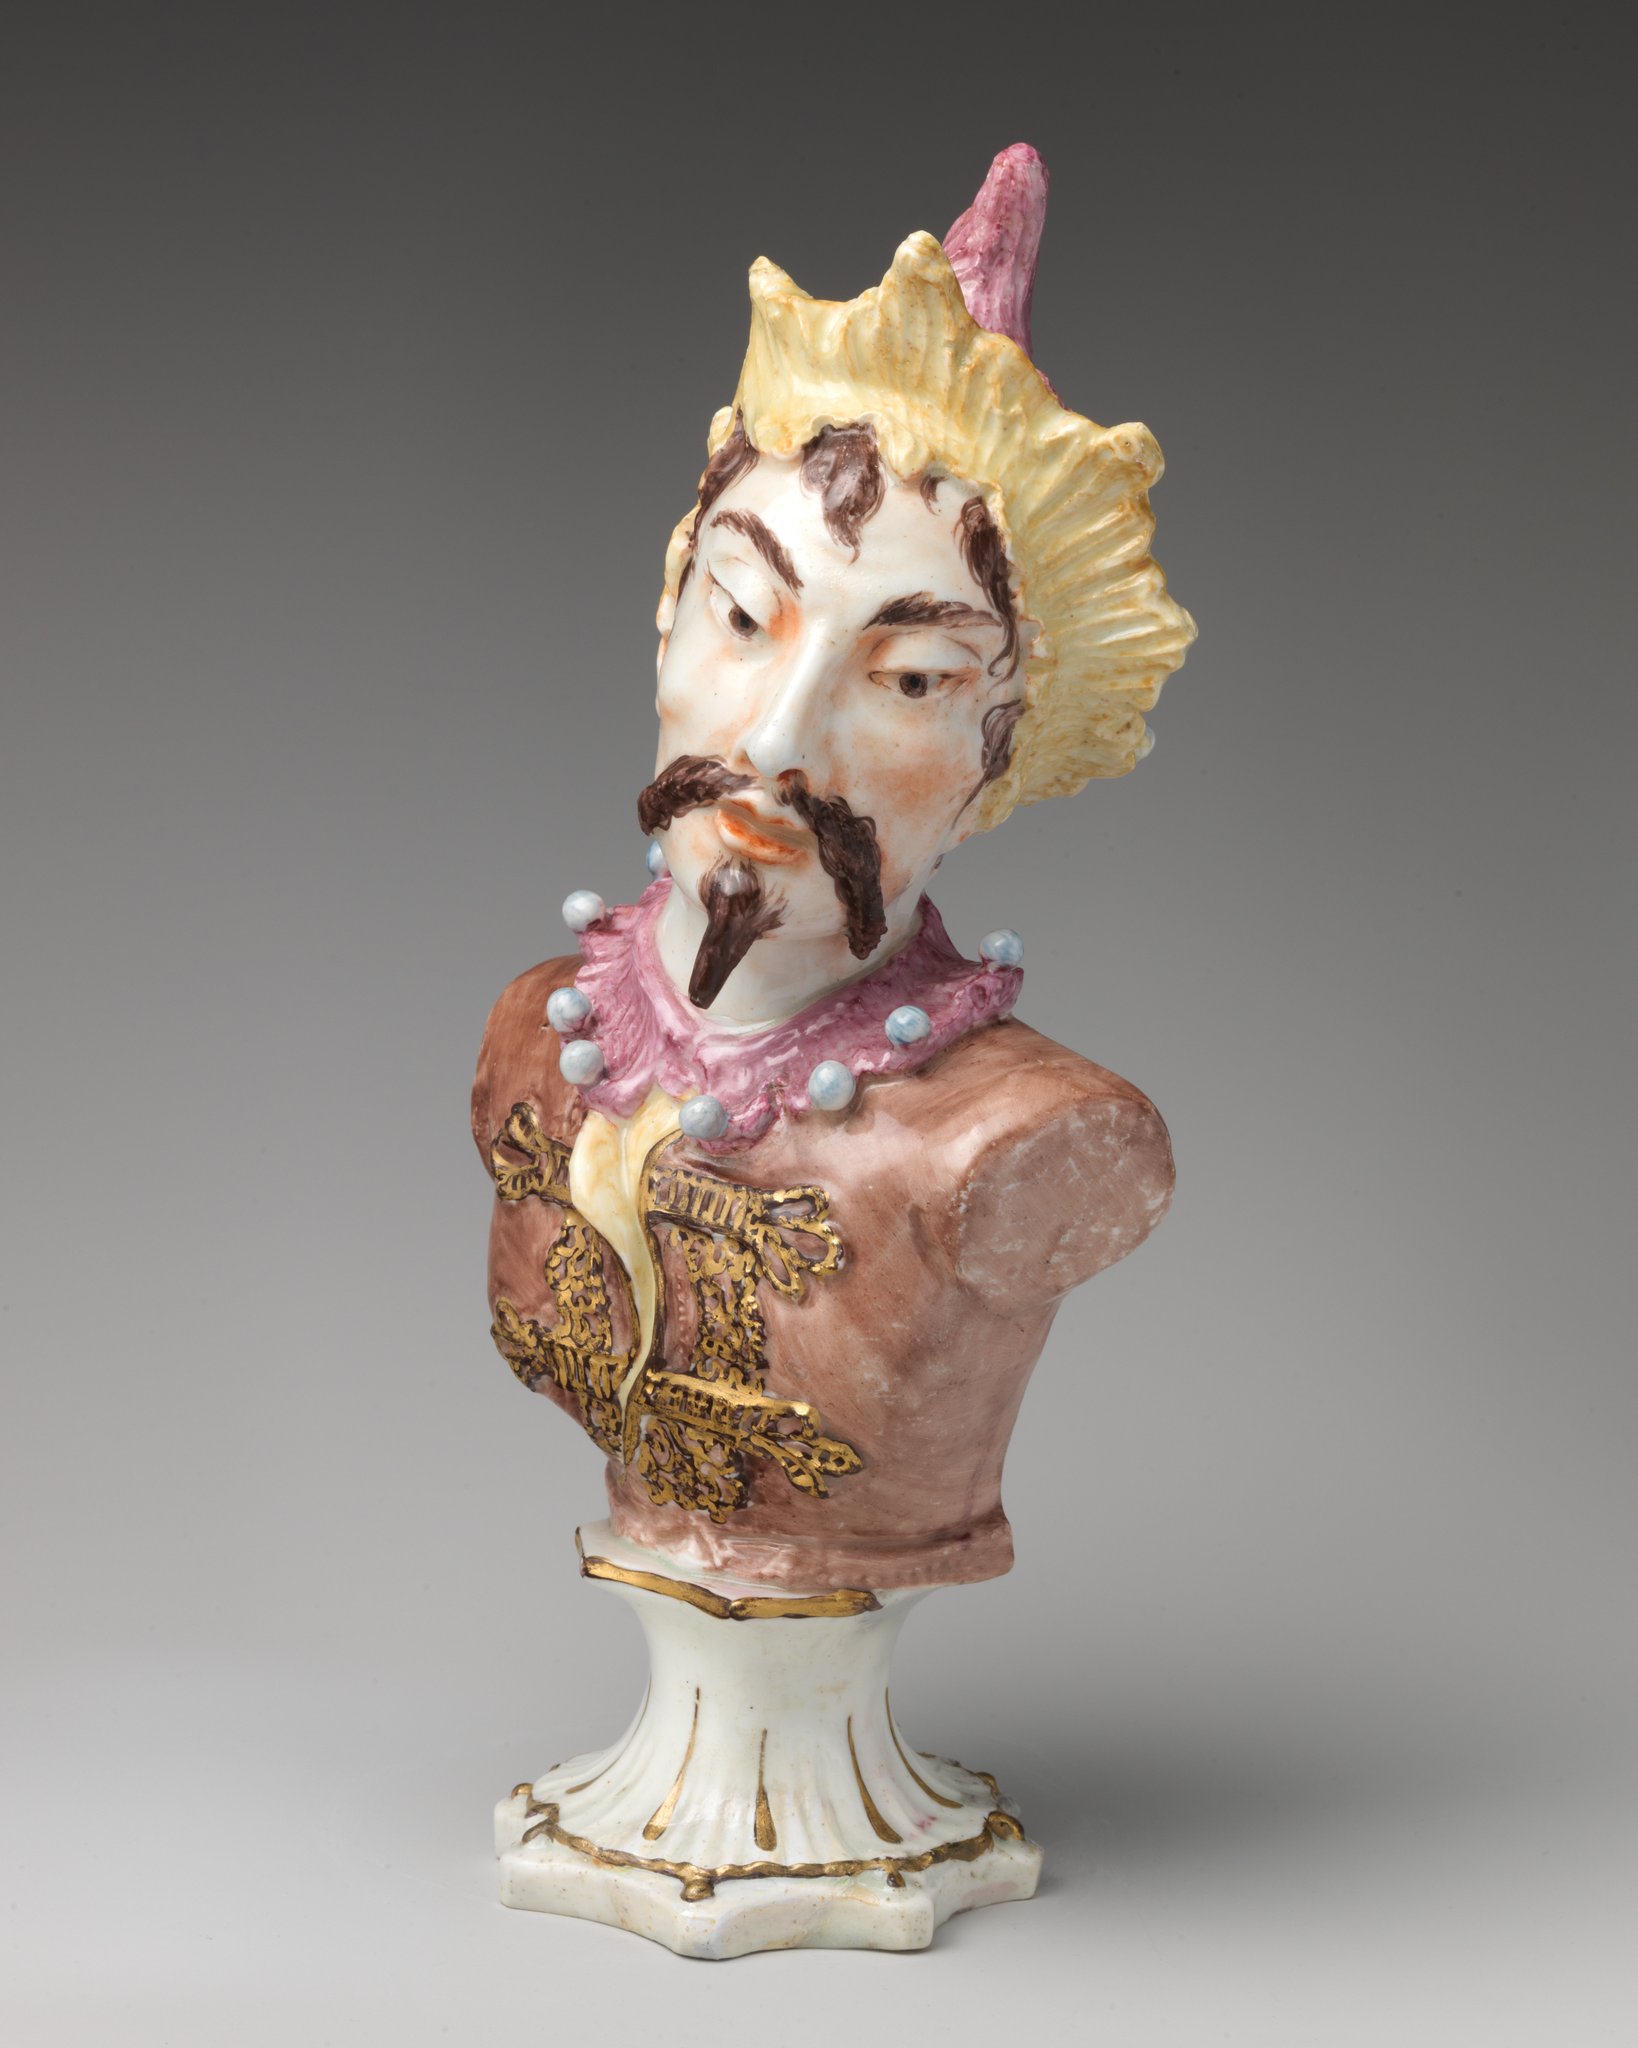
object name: figure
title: A Mongolian man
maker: bow porcelain factory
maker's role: factory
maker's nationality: british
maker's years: 1747-1776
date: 1750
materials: soft paste porcelain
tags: men,portraits,women